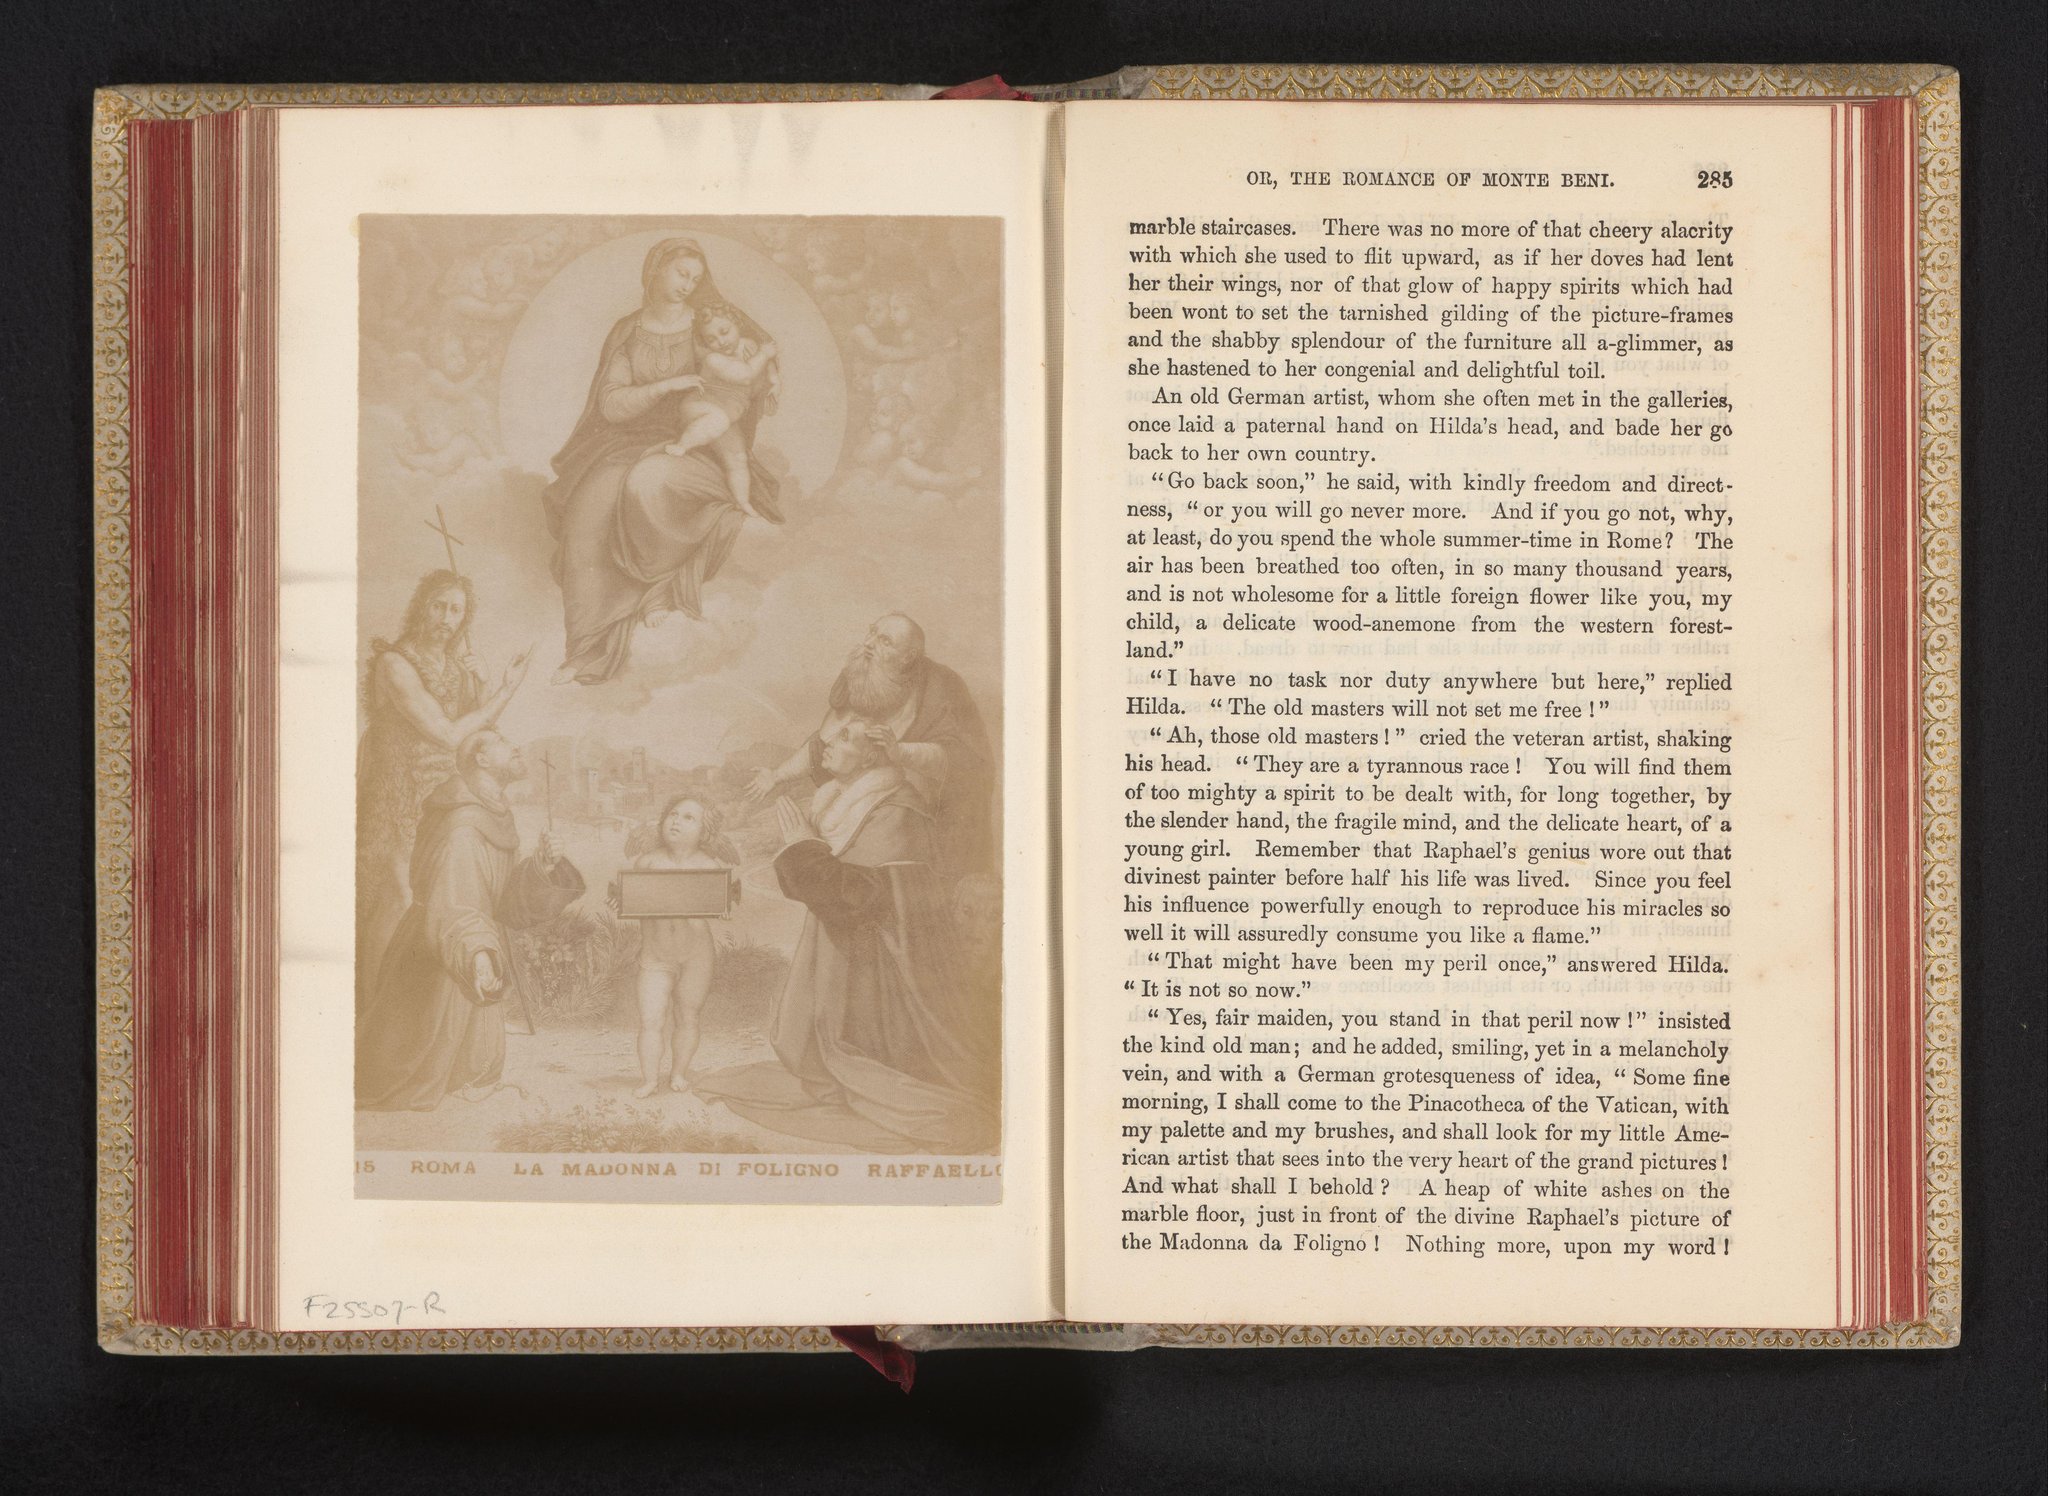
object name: photograph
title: Fotoreproductie van het schilderij 'Madonna di Foligno' door Rafaël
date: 1883-1888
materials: paper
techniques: albumen print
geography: rome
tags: madonna: i.e. mary with the christ-child, rome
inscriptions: number: ‘[...5]’